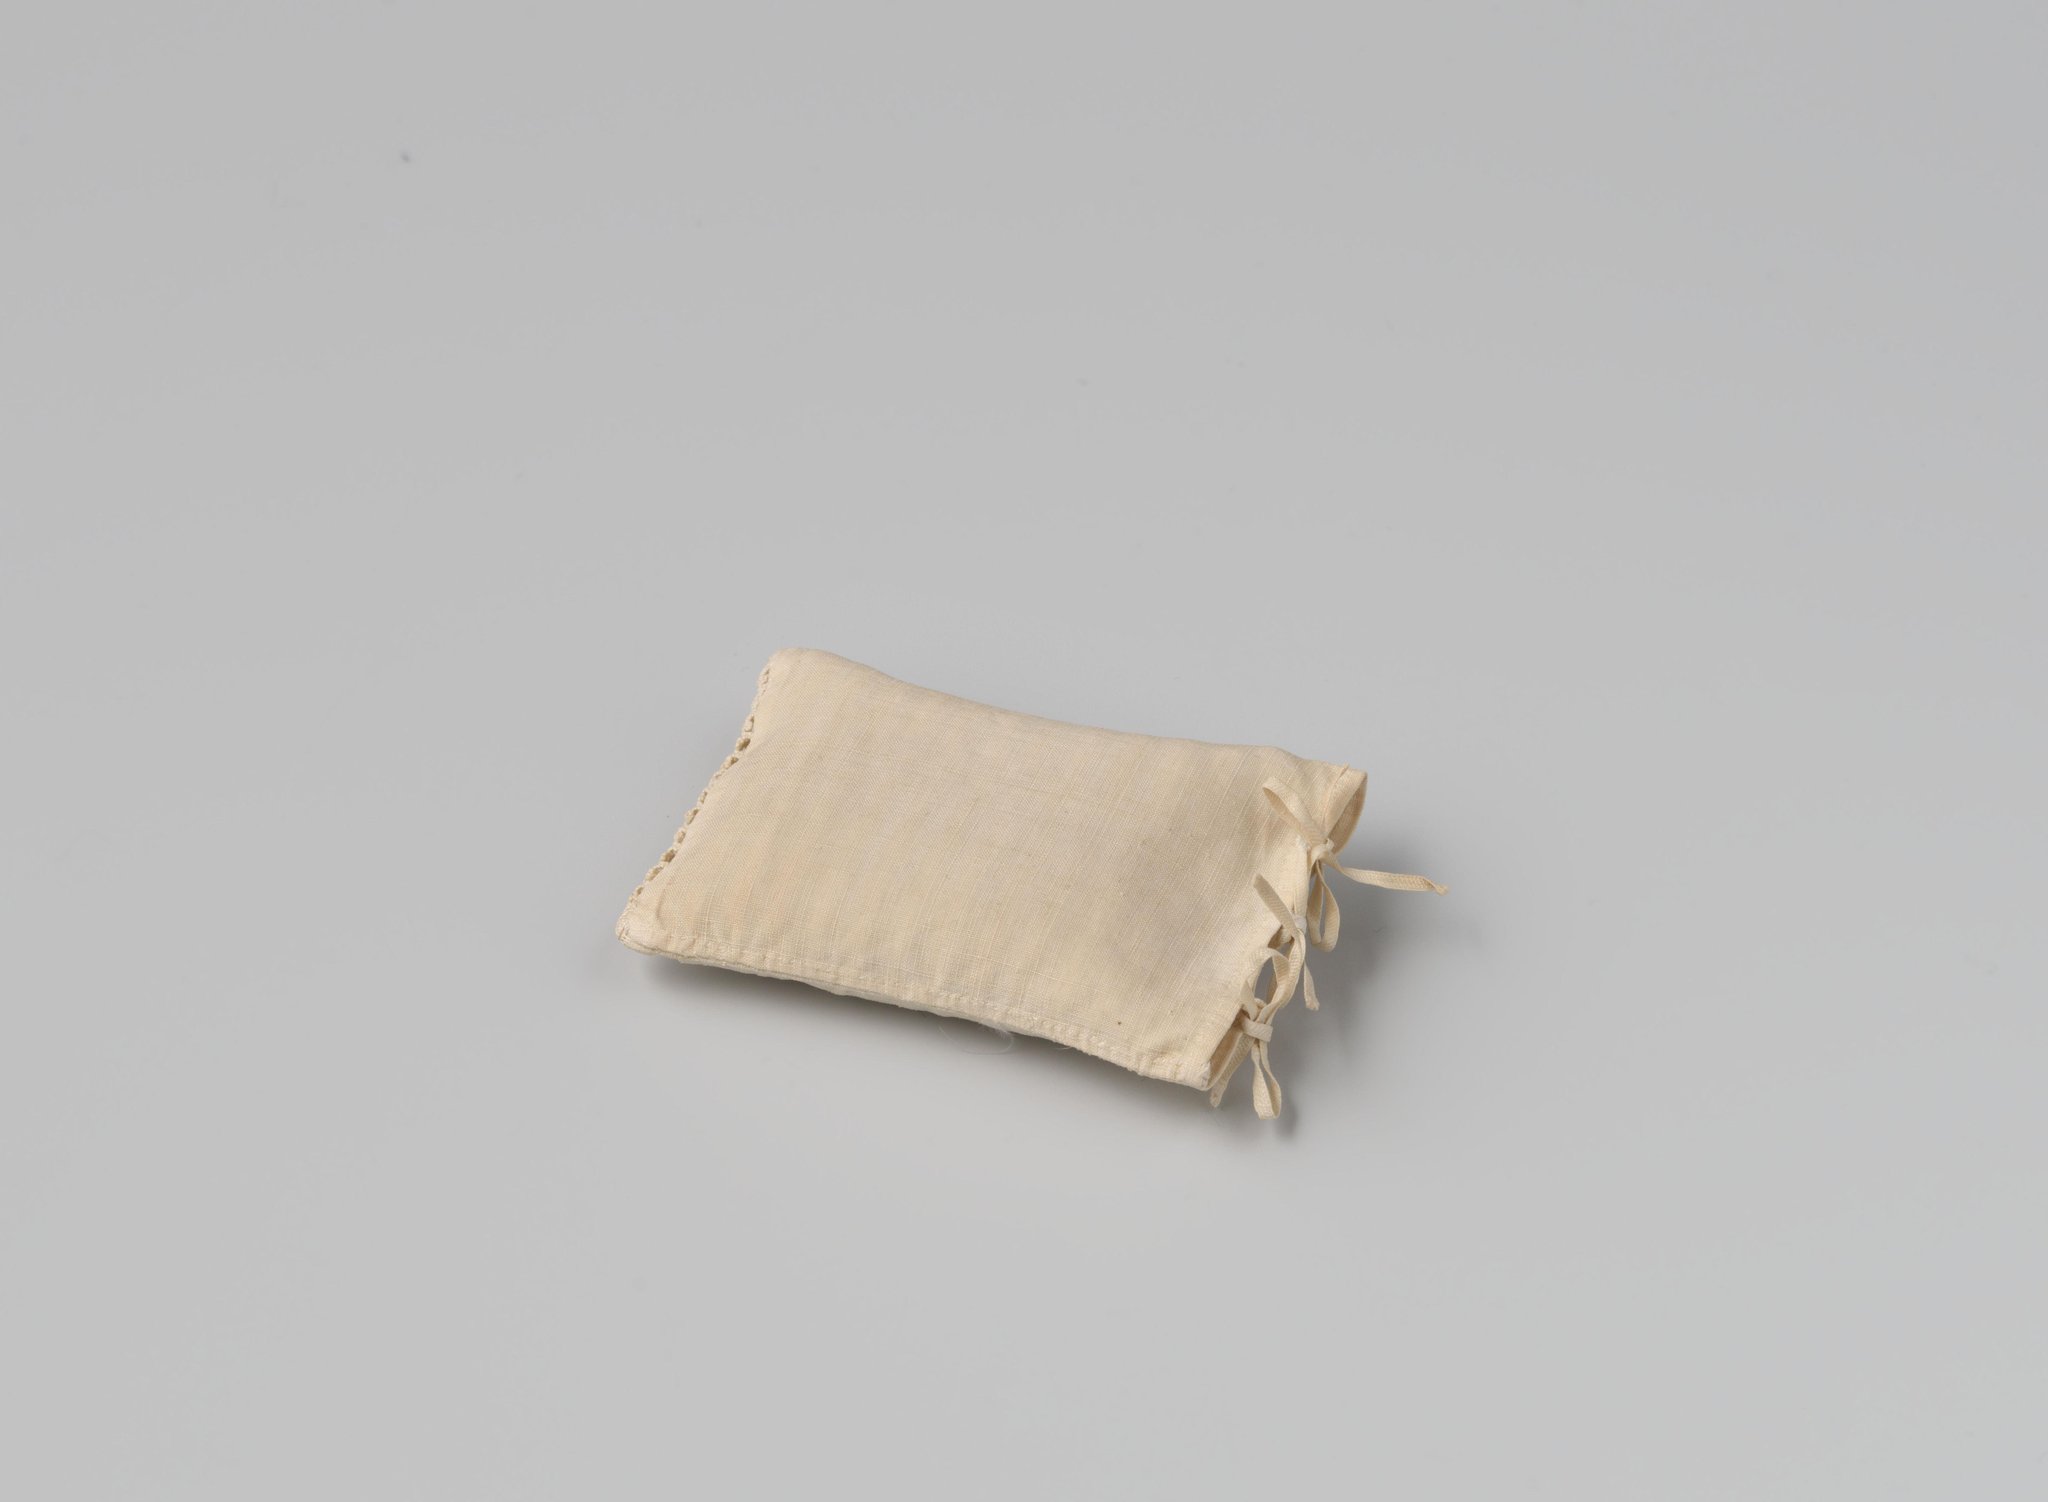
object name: sloop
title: Sloop van wit linnen met een tussenzetsel aan één zijde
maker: Anonymous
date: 1690-1710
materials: linen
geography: amsterdam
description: Sloop van wit linnen, met een tussenzetzel aan één smalle zijde. De sluiting bestaat uit twee keer drie sluitbanden, die aan de zoom zijn vastgezet.